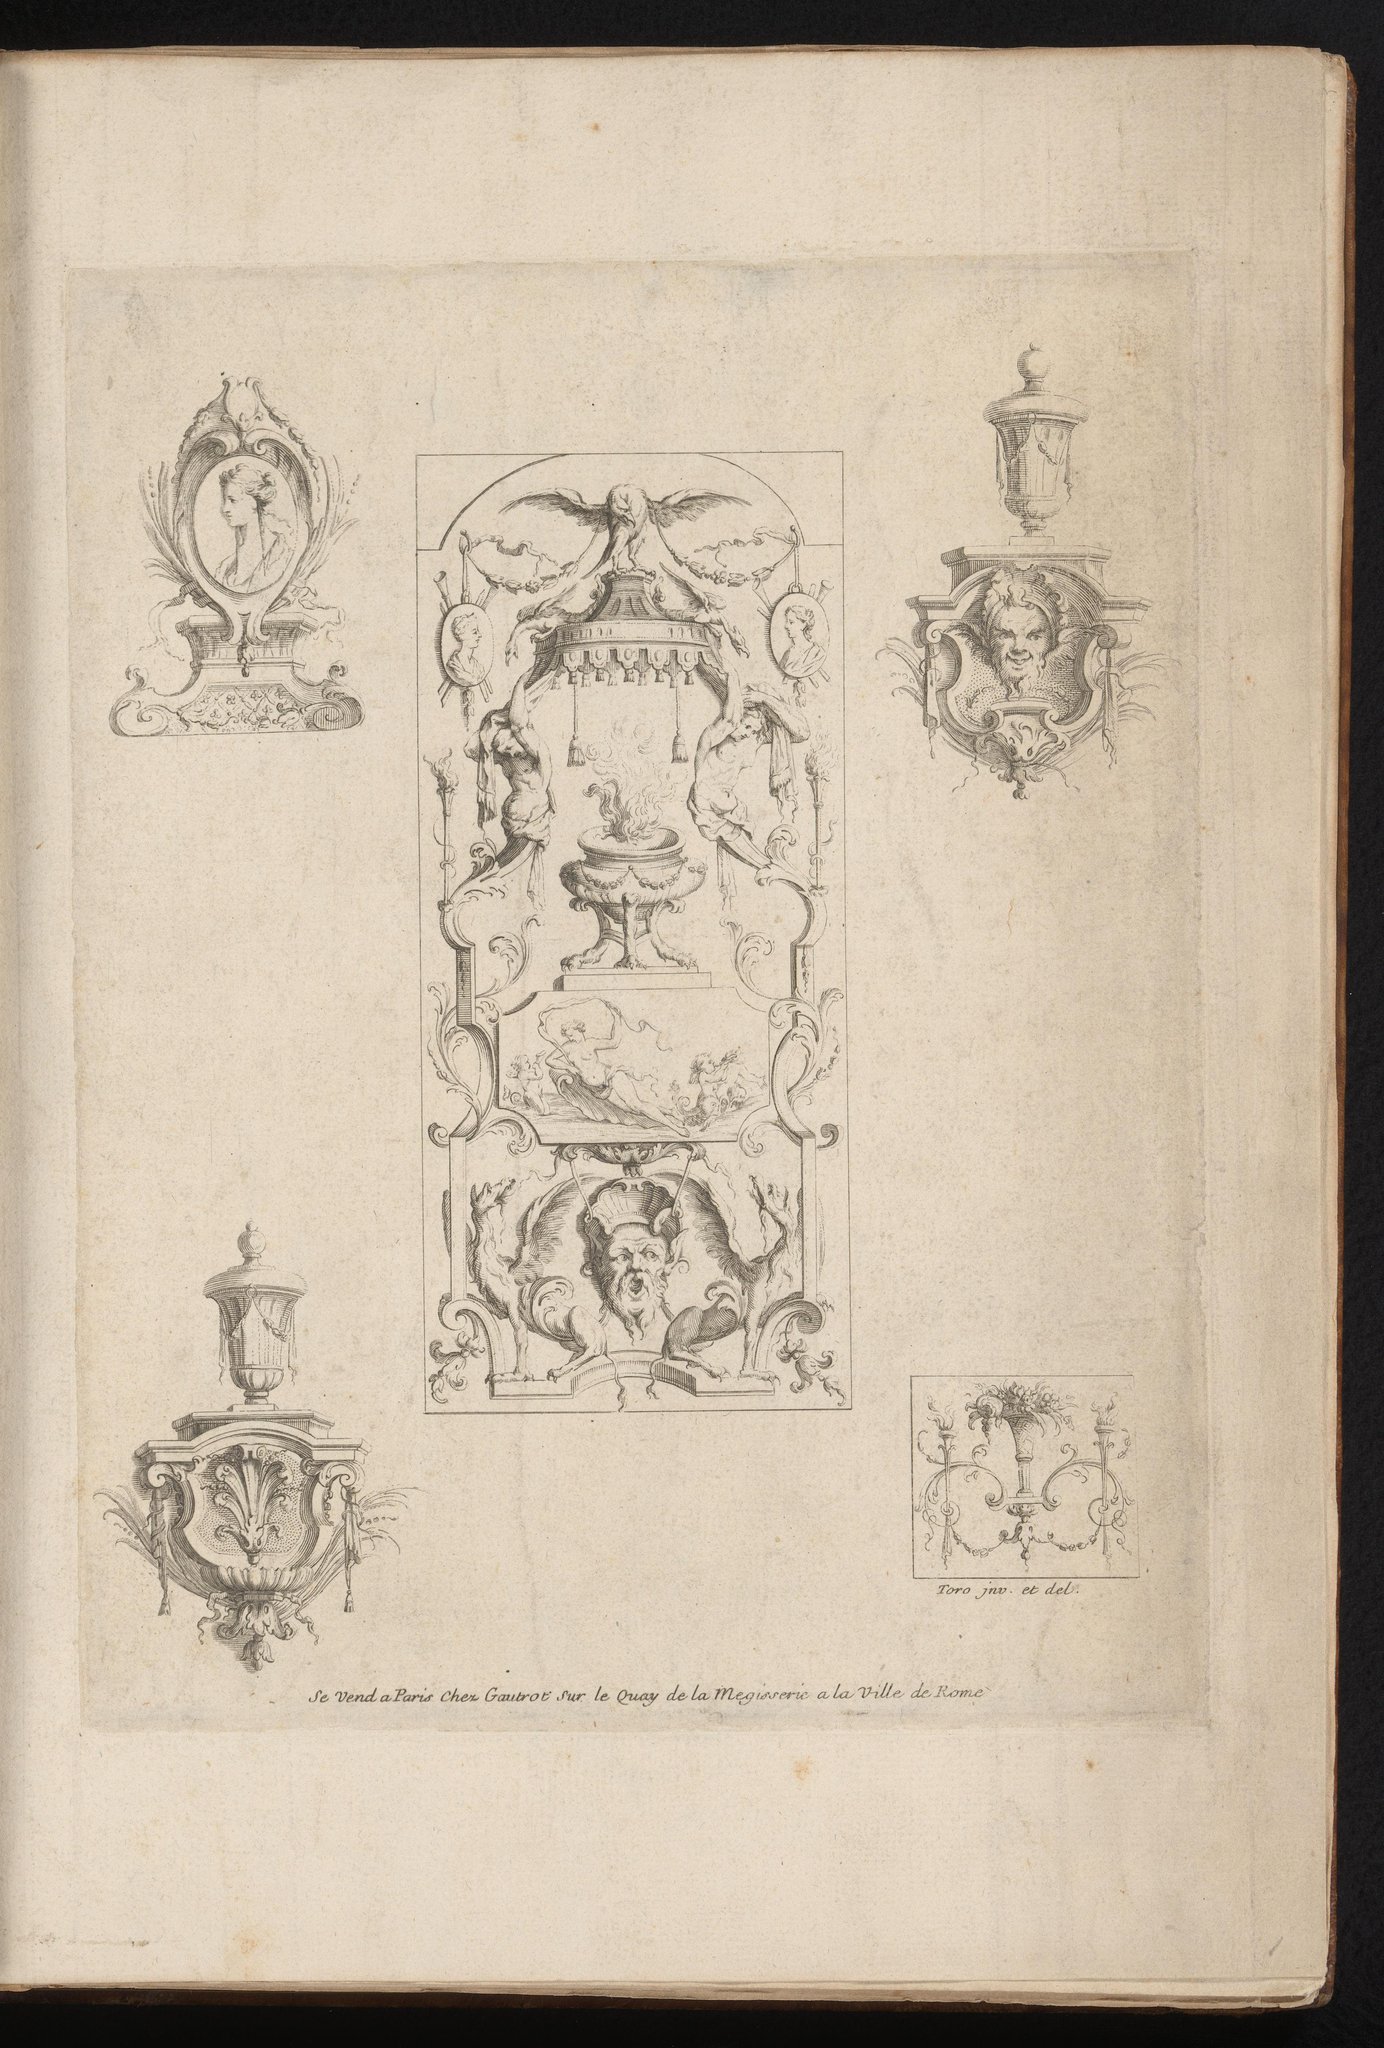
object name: album leaf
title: Paneel met Venus en vier losse ornamenten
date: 1705-1730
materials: paper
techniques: etching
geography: paris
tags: predatory birds: eagle, venus, standing on a shell, sails with her veil over the water (alternatively she is riding on a dolphin): venus marina, mask, mascaron ~ ornament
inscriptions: collector's mark: Lugt 2760, collector's mark: Lugt 2228